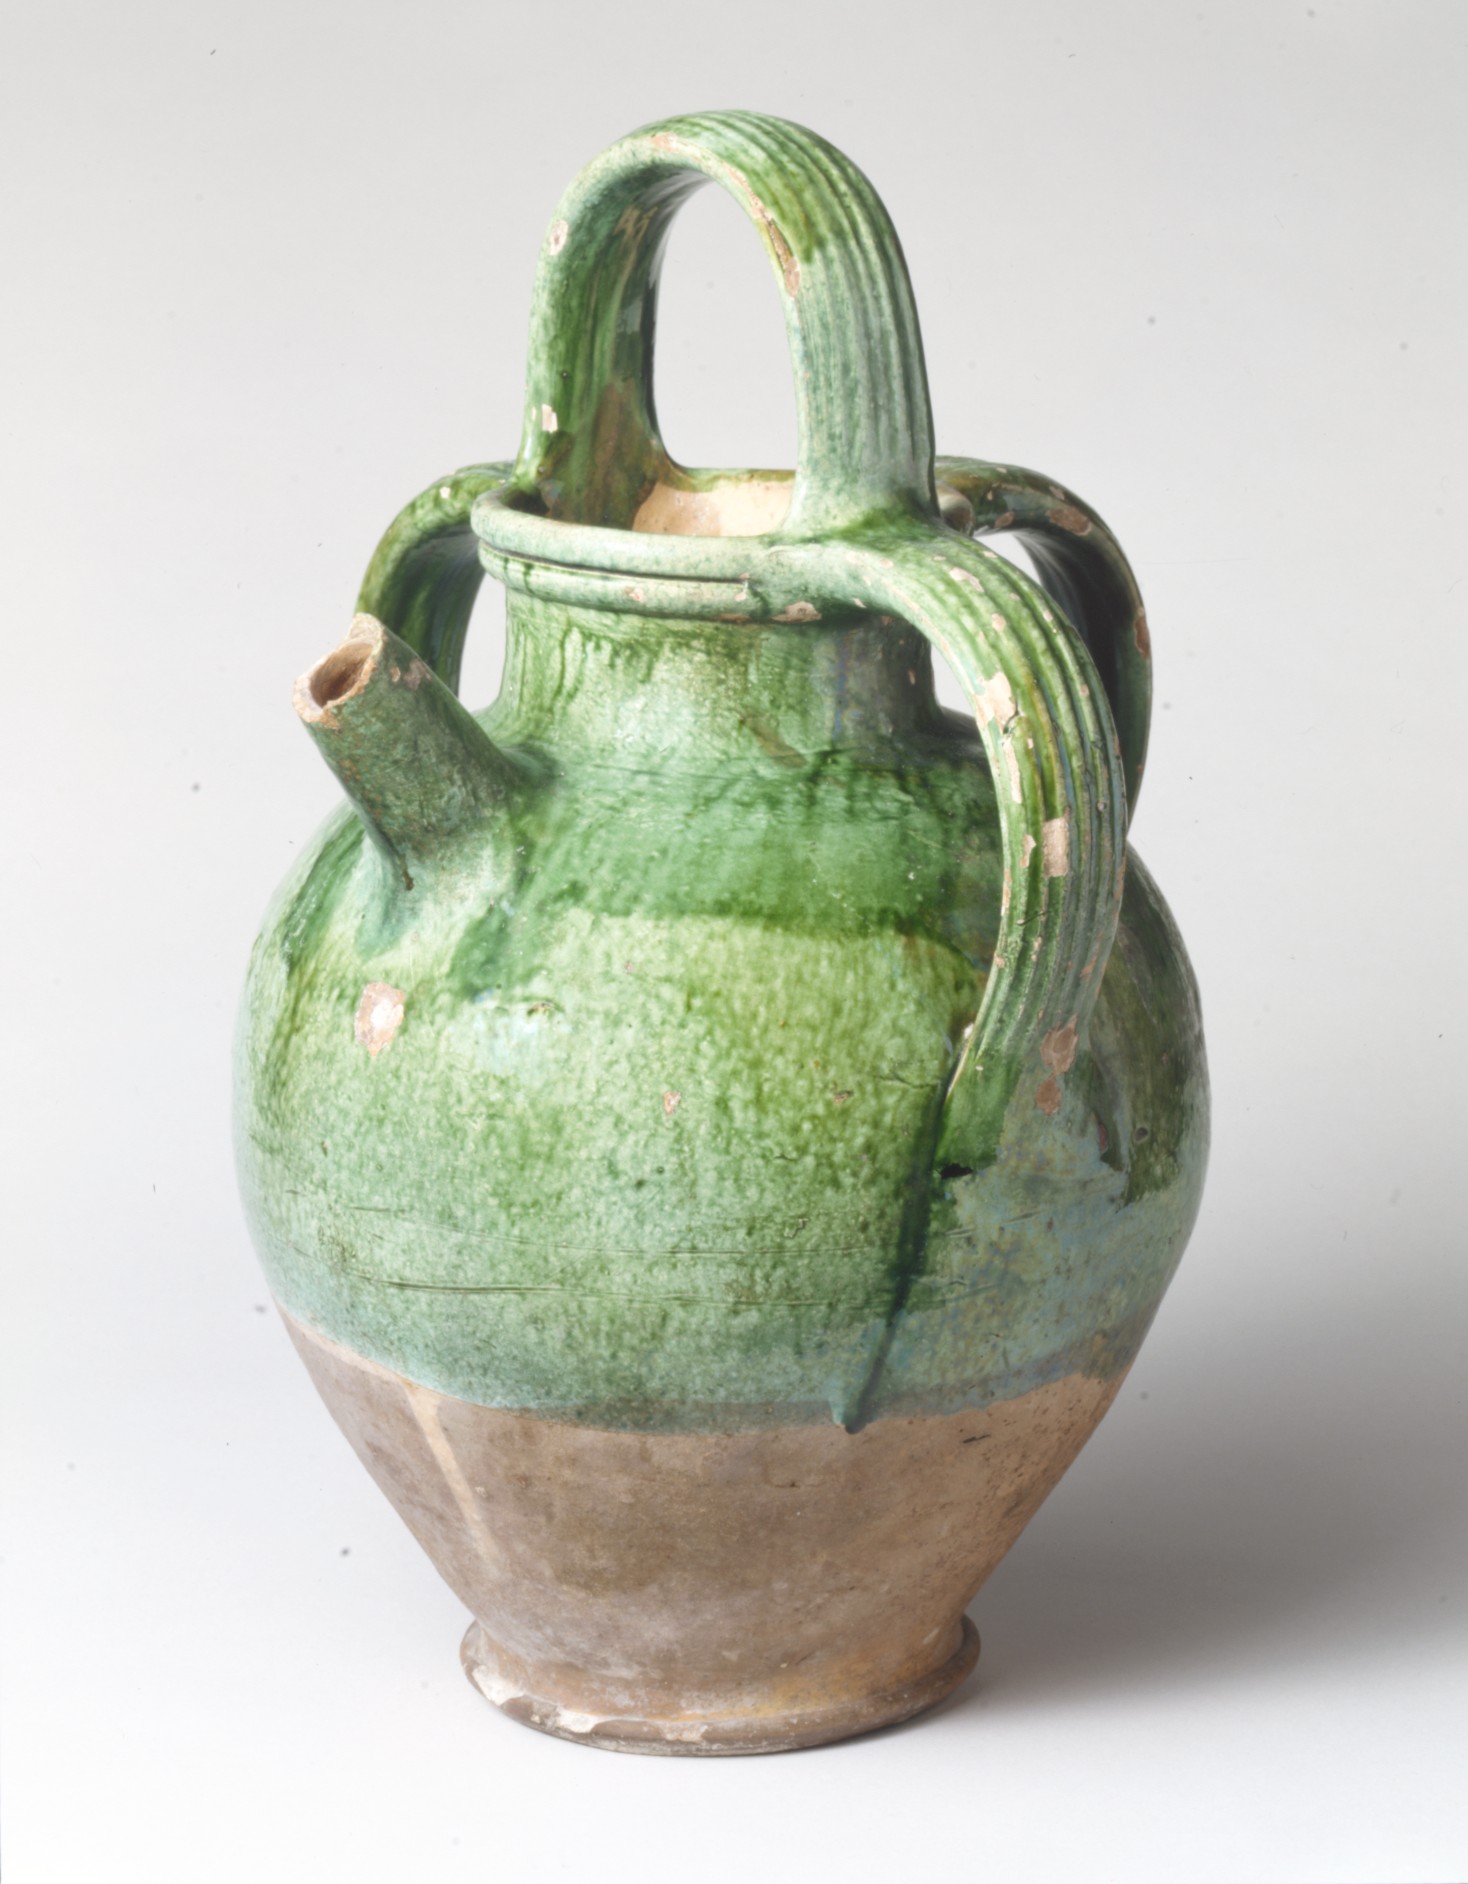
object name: water jar with spout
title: Water jar with spout (vase à bec)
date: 1551-1600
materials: earthenware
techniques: glazing